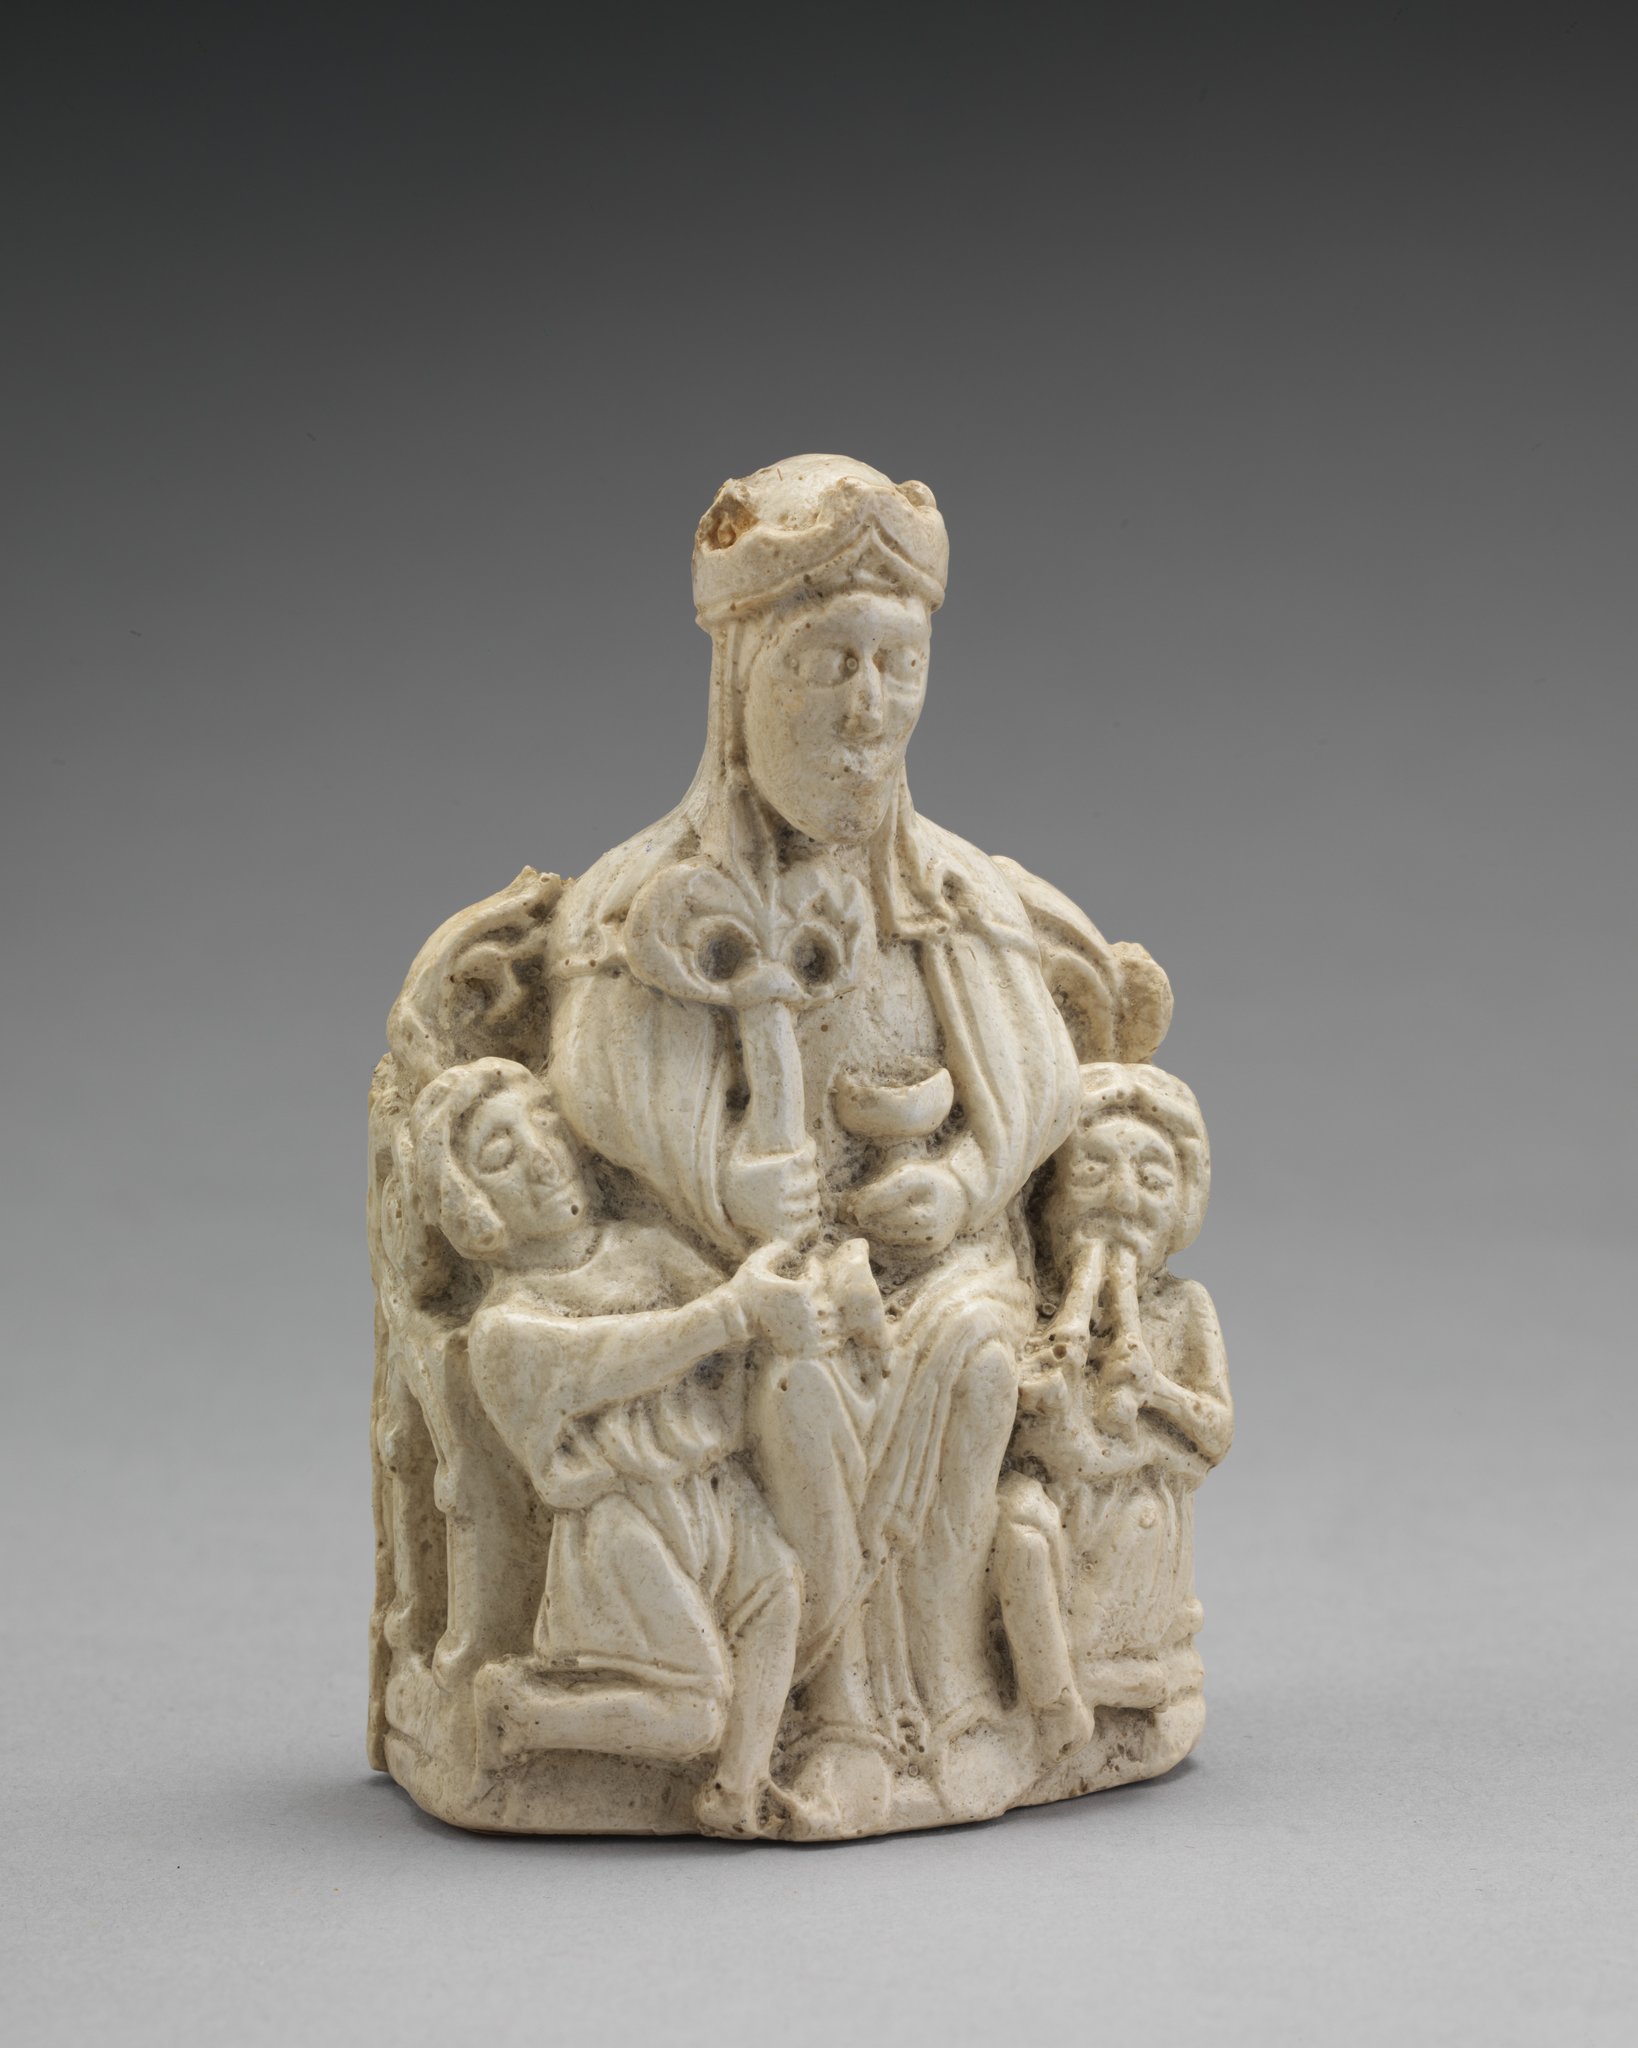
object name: chessman queen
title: Chessman (Queen)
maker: elkington & co.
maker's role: manufacturer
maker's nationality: british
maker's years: 1829-1963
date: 1870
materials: ivory, plaster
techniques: painting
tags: chess